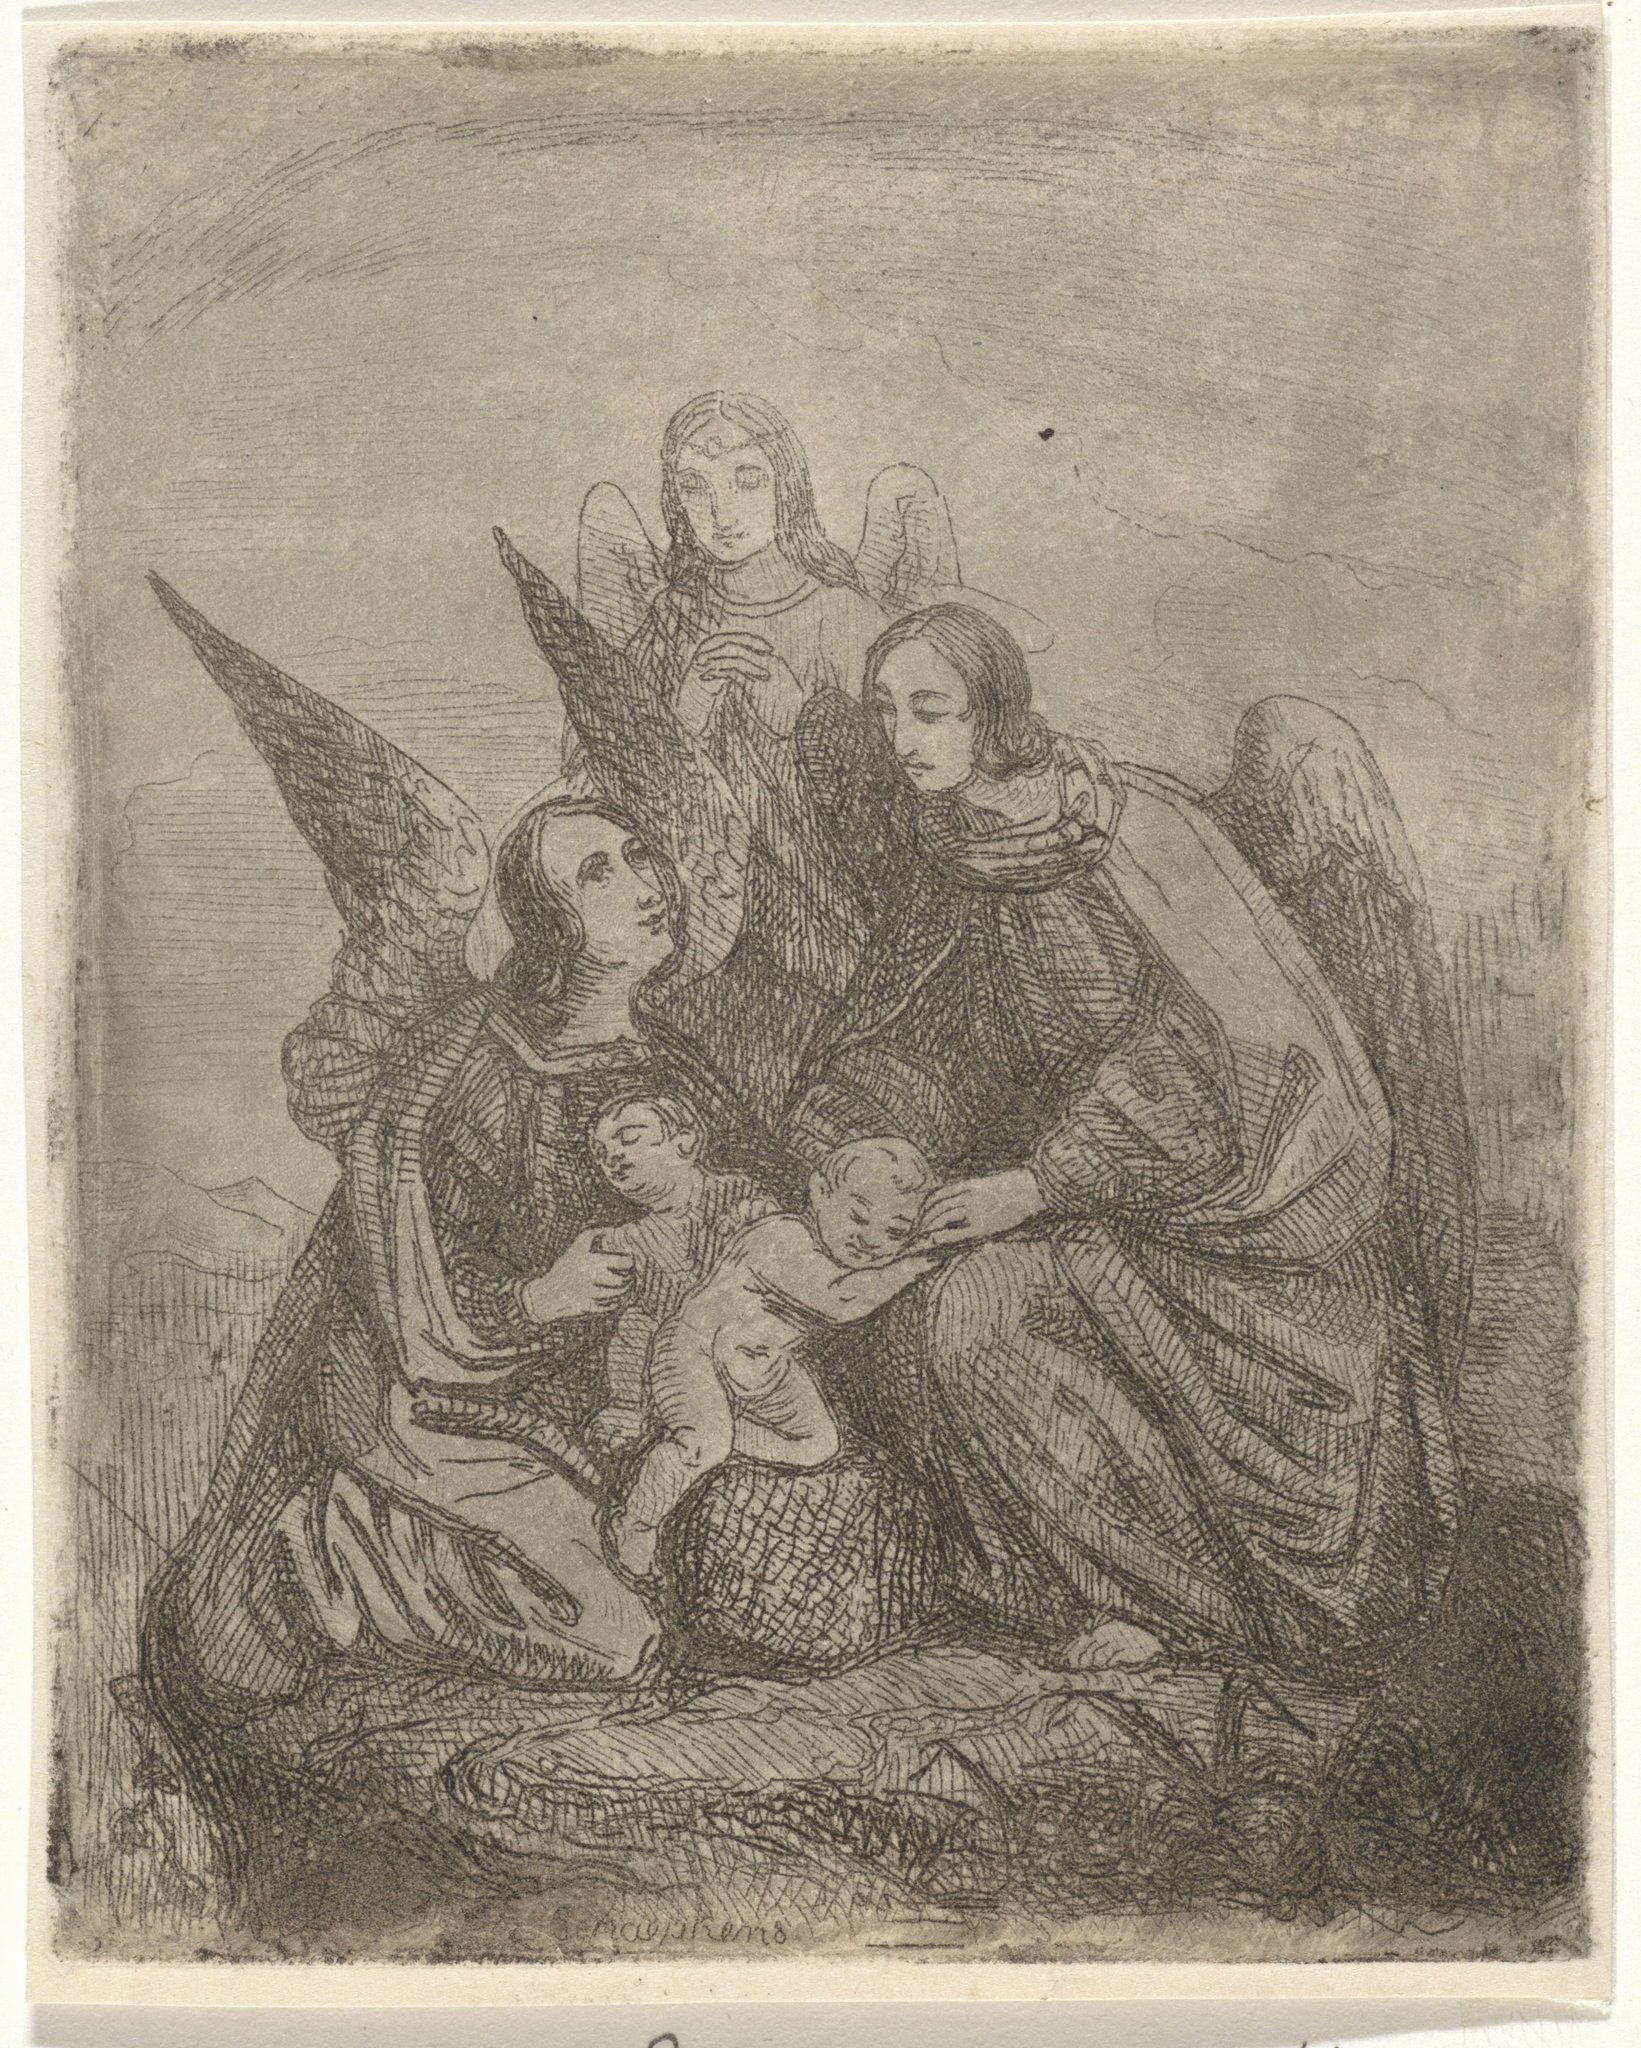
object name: print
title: Beschermengelen ontfermen zich over twee kleine kinderen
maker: theodoor schaepkens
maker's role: draughtsman, print maker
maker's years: 1810-1883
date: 1825-1883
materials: paper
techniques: etching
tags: guardian angel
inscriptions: collector's mark: Lugt 2228